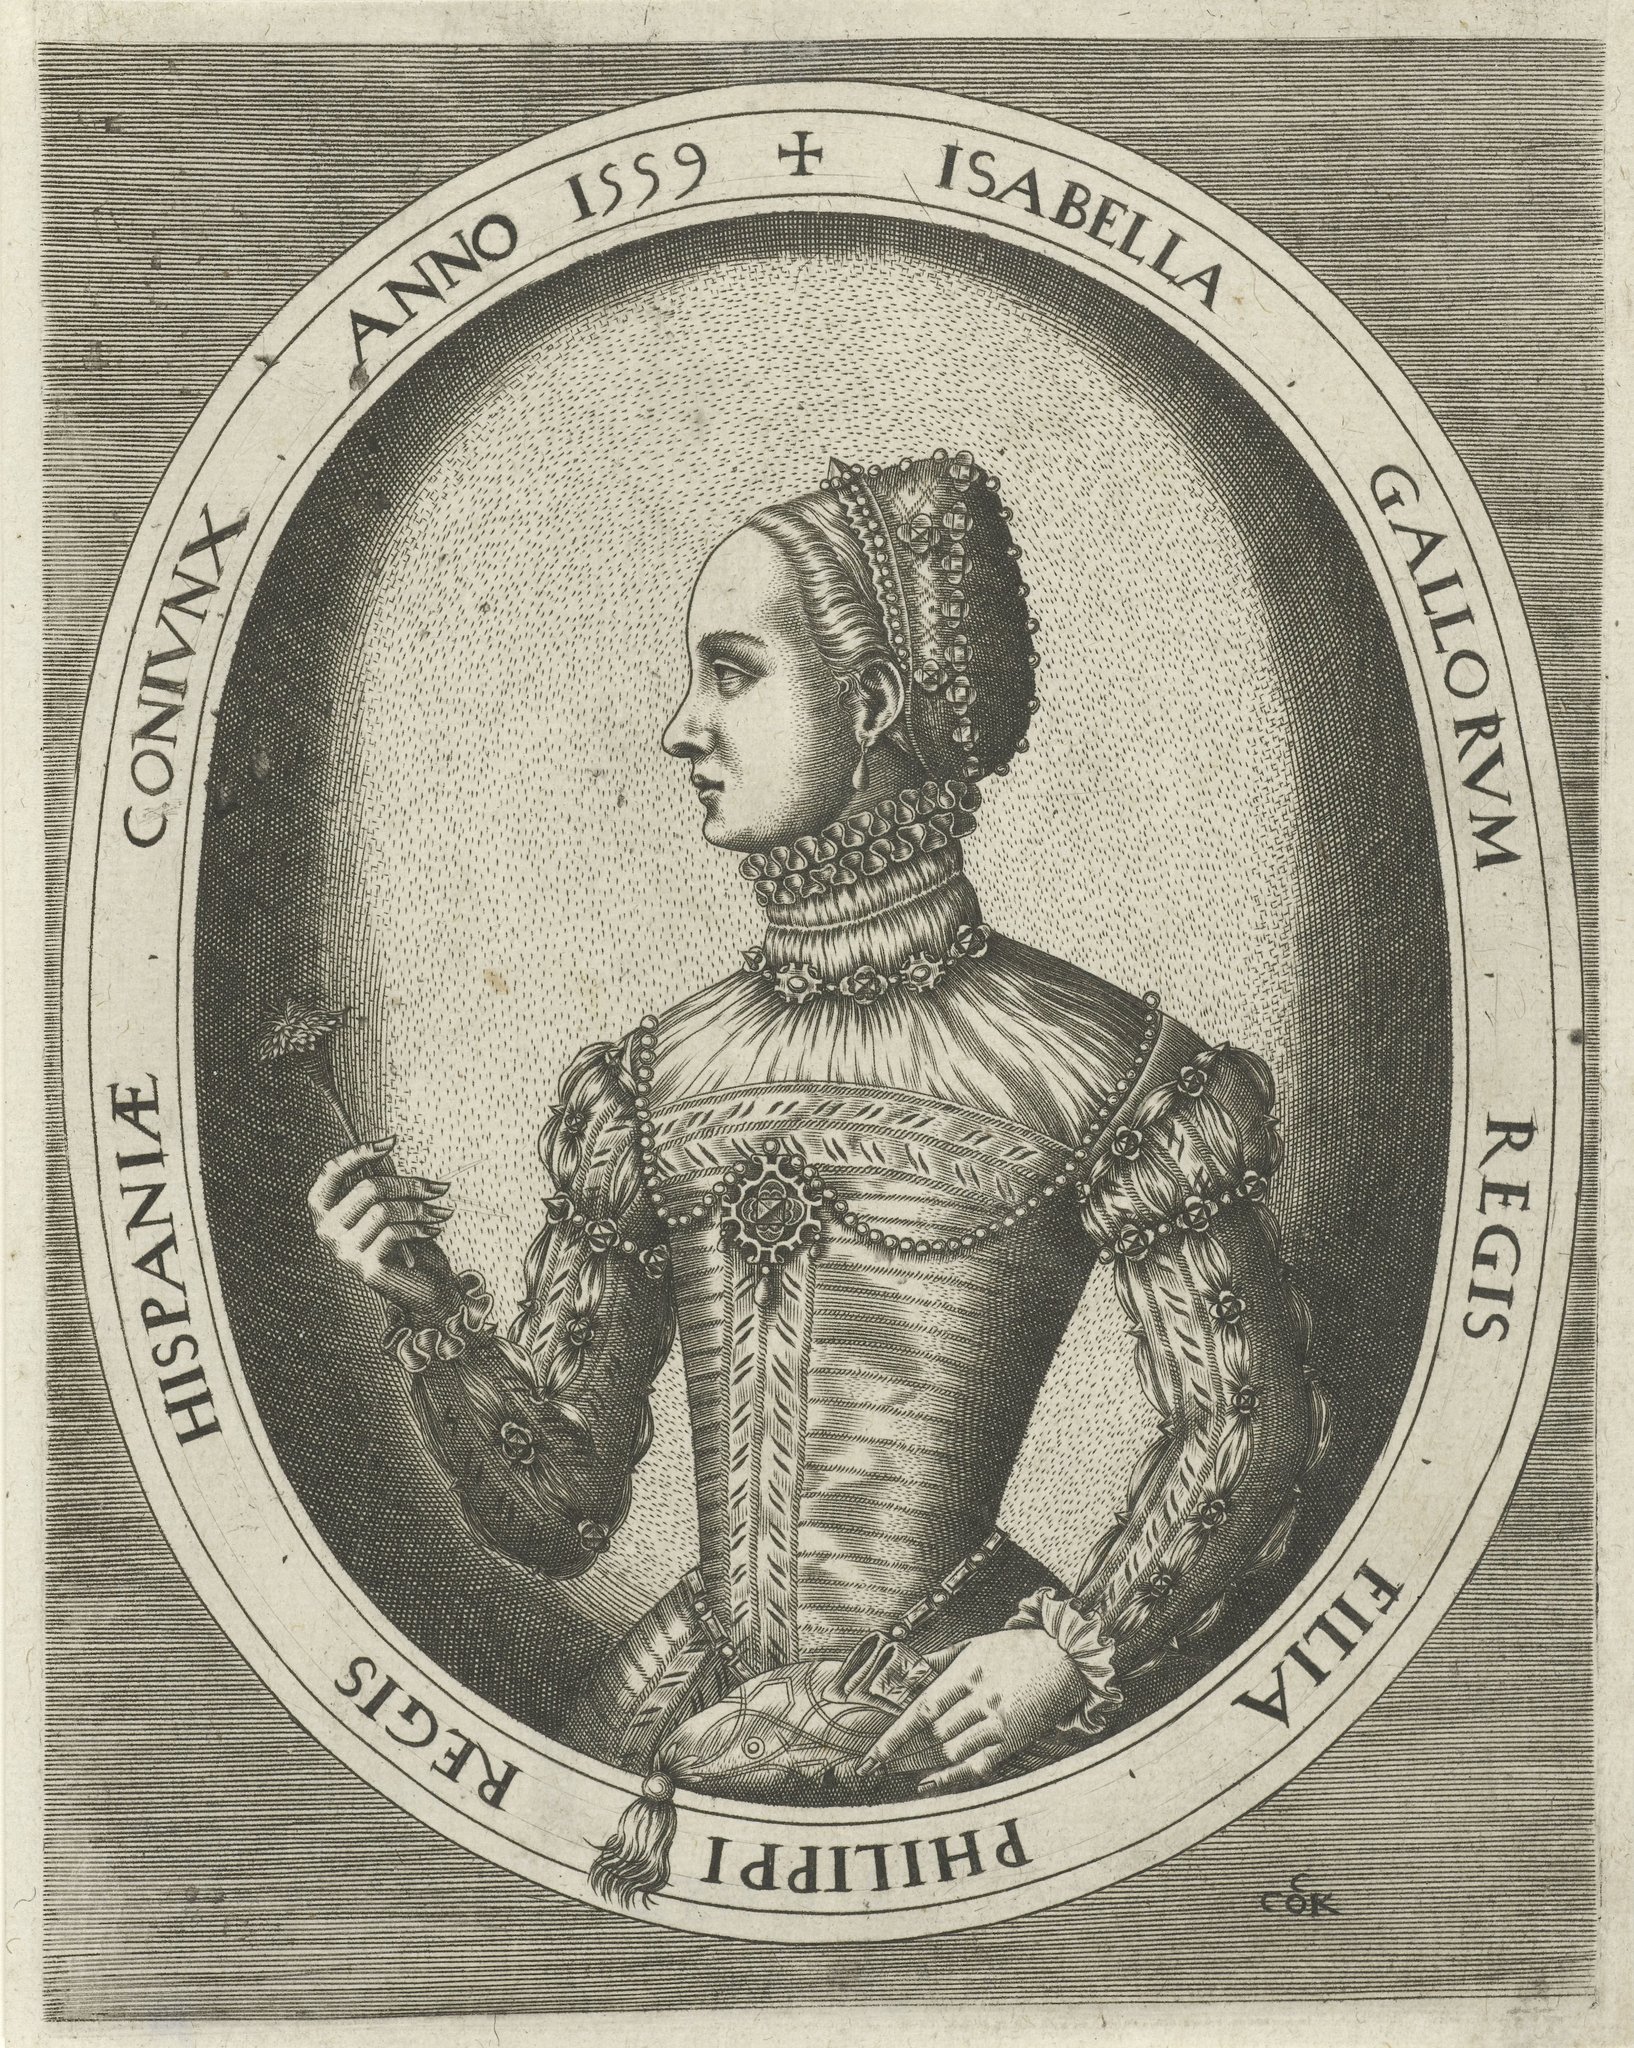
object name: print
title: Portret van Elisabeth van Valois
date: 1559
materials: paper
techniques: engraving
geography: antwerp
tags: fontainebleau, madrid, koningin, elisabeth van valois (koningin van spanje)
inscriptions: collector's mark: Lugt 2228, collector's mark: Lugt 1490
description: Portret van Elisabeth van Valois, koningin van Spanje, ten halven lijve naar links in een ovale lijst met randschrift in het Latijn. Zij houdt een bloem in haar rechterhand en een paar handschoenen in haar linkerhand.